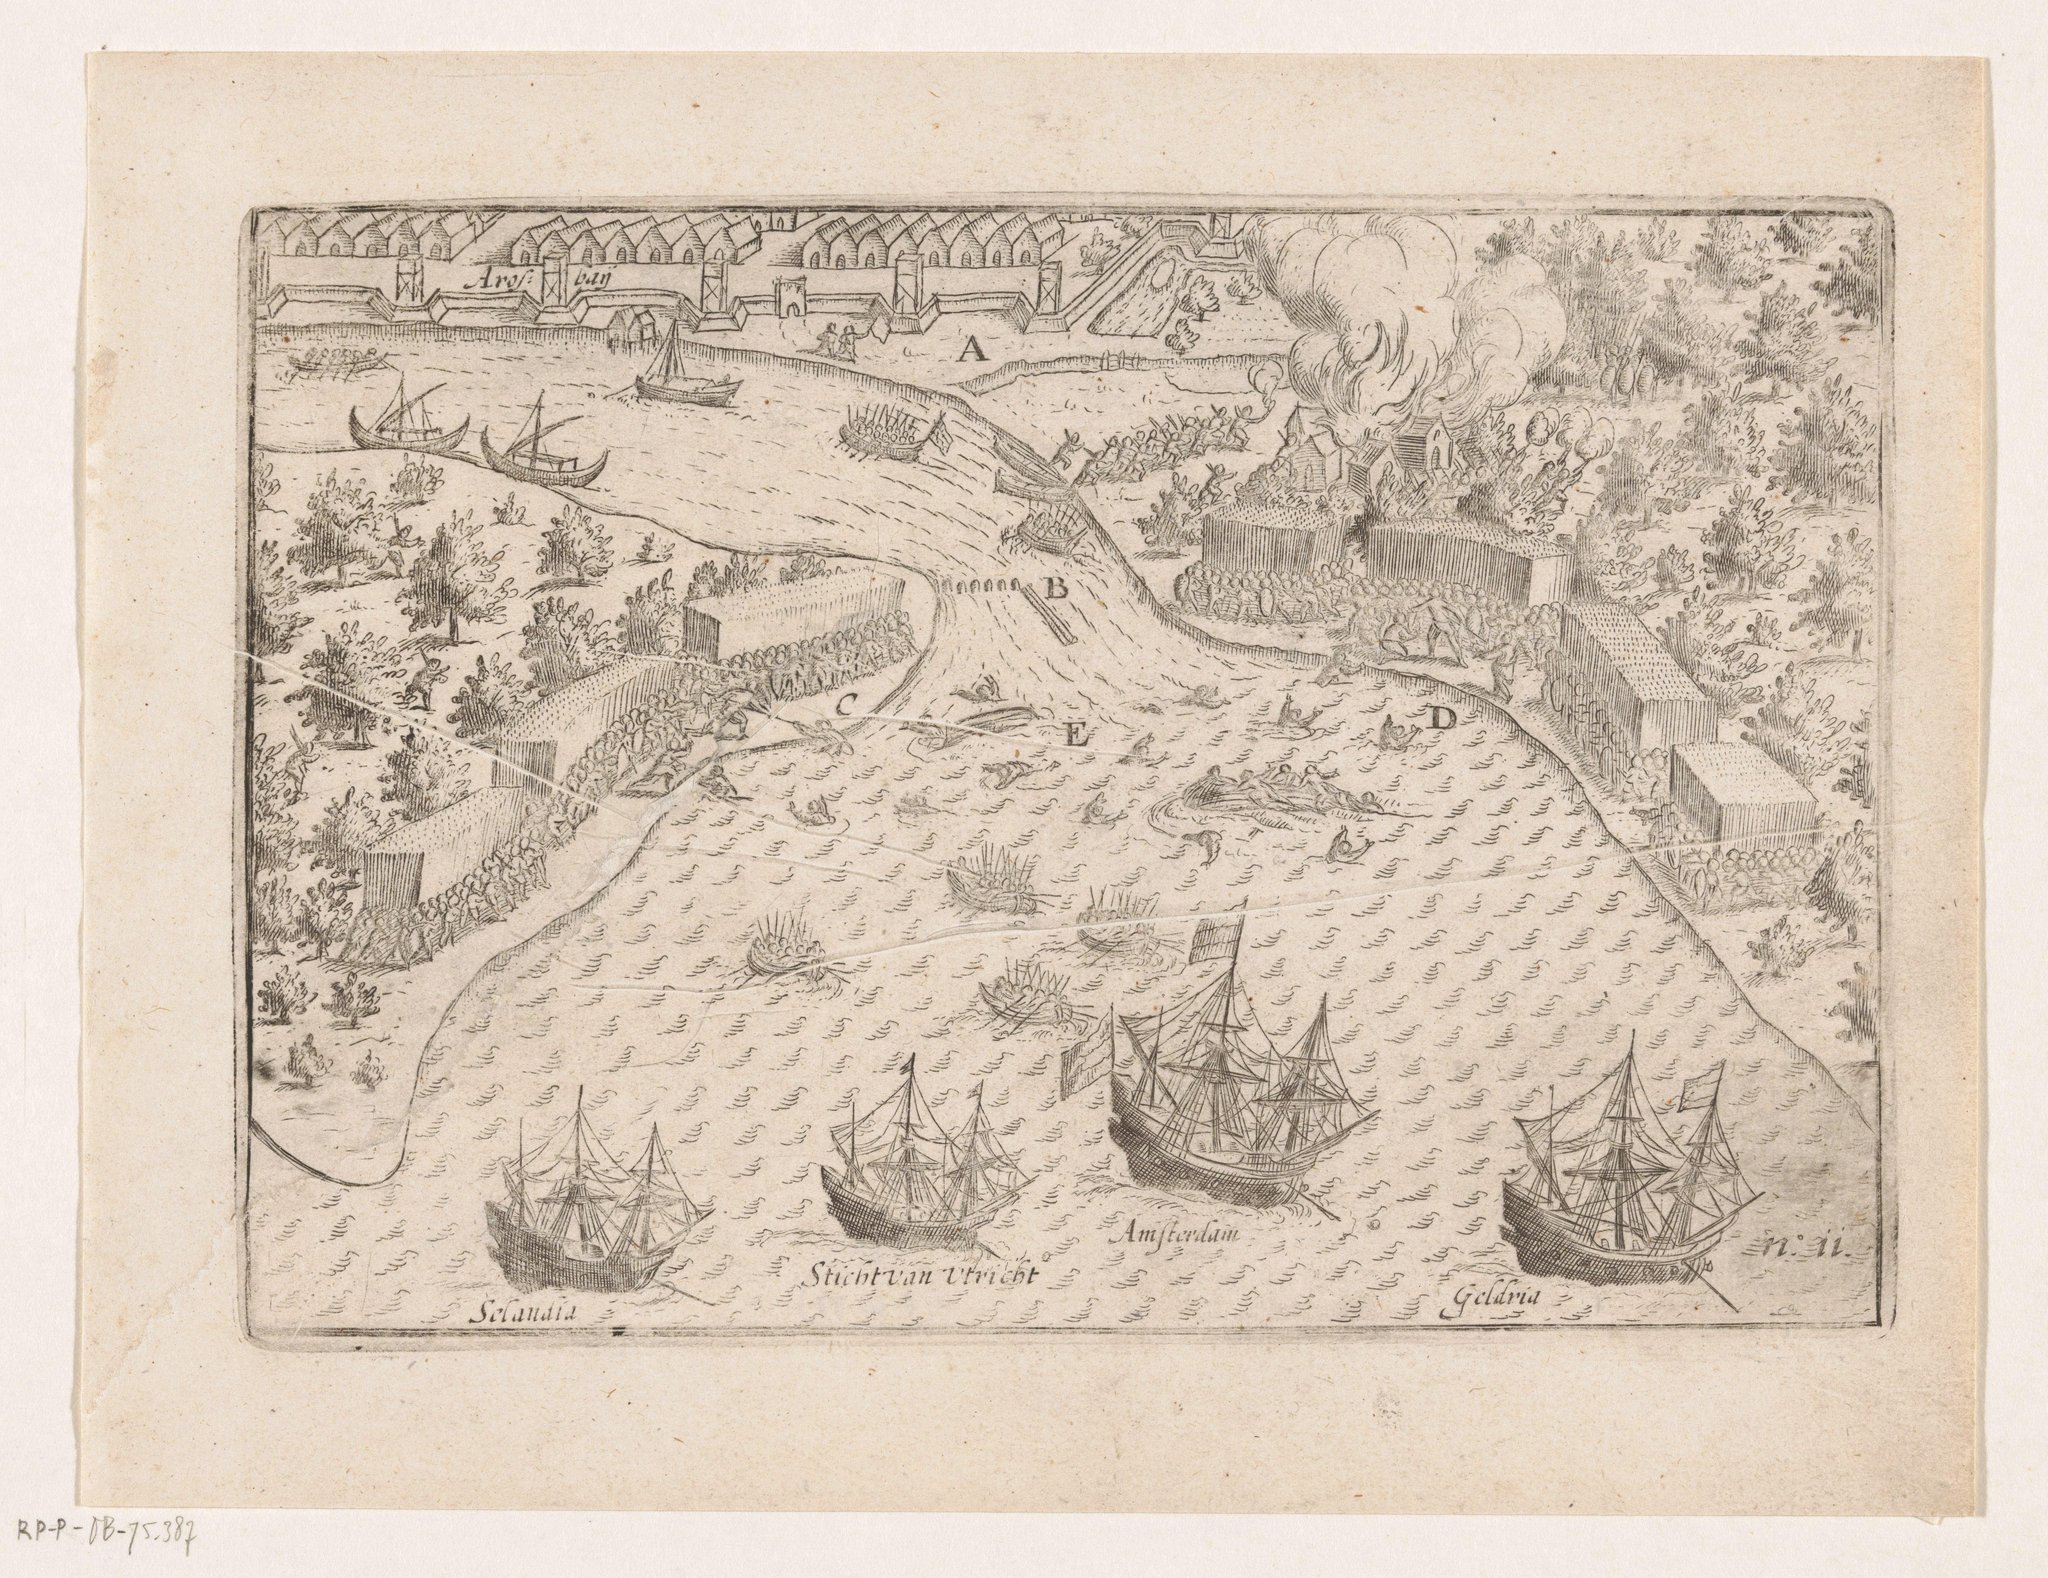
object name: print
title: Slag bij de Arosbaai op Madura, 1599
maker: Anonymous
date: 1600-1601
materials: paper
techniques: engraving, etching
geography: northern netherlands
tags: mayor, landscapes in tropical and sub-tropical regions, exploration, expedition, voyage of discovery, madura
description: Gebruikt als illustratie eerst in: Journael ofte Dagh-register, inhoudende een waerachtigh verhael ... vande reyse, ghedaen door de acht schepen van Amsterdamme, onde 'tbeleydt van Iacob Cornelisz. Neck. als Admirael, ende VVybrandt van VVarvvijck, als Vice-admirael, van Amsterdam gheseylt inden jare 1598, Cornelis Claes, Amsterdam [1600], plaat No. 4. In deze staat gebruikt in: Oost-Indische ende West-Indische voyagien, Michiel Colijn, Amsterdam 1619 en later in: Waerachtigh verhael van de Schipvaerd op Oost-Indien ghedaen by de acht Schepen in den jare 1598 van Amsterdam uyt-ghezeylt, onder 't beleyd van den Admirael Jacob Cornelissoon van Neck, ende Vice-Admirael Wybrand van Warwijck. Opgenomen in: I. Commelin, Begin ende voortgangh, van de Vereenighde Nederlantsche Geoctroyeerde Oost-Indische Compagnie, J. Janssonius, Amsterdam 1646. Genummerd: 11.